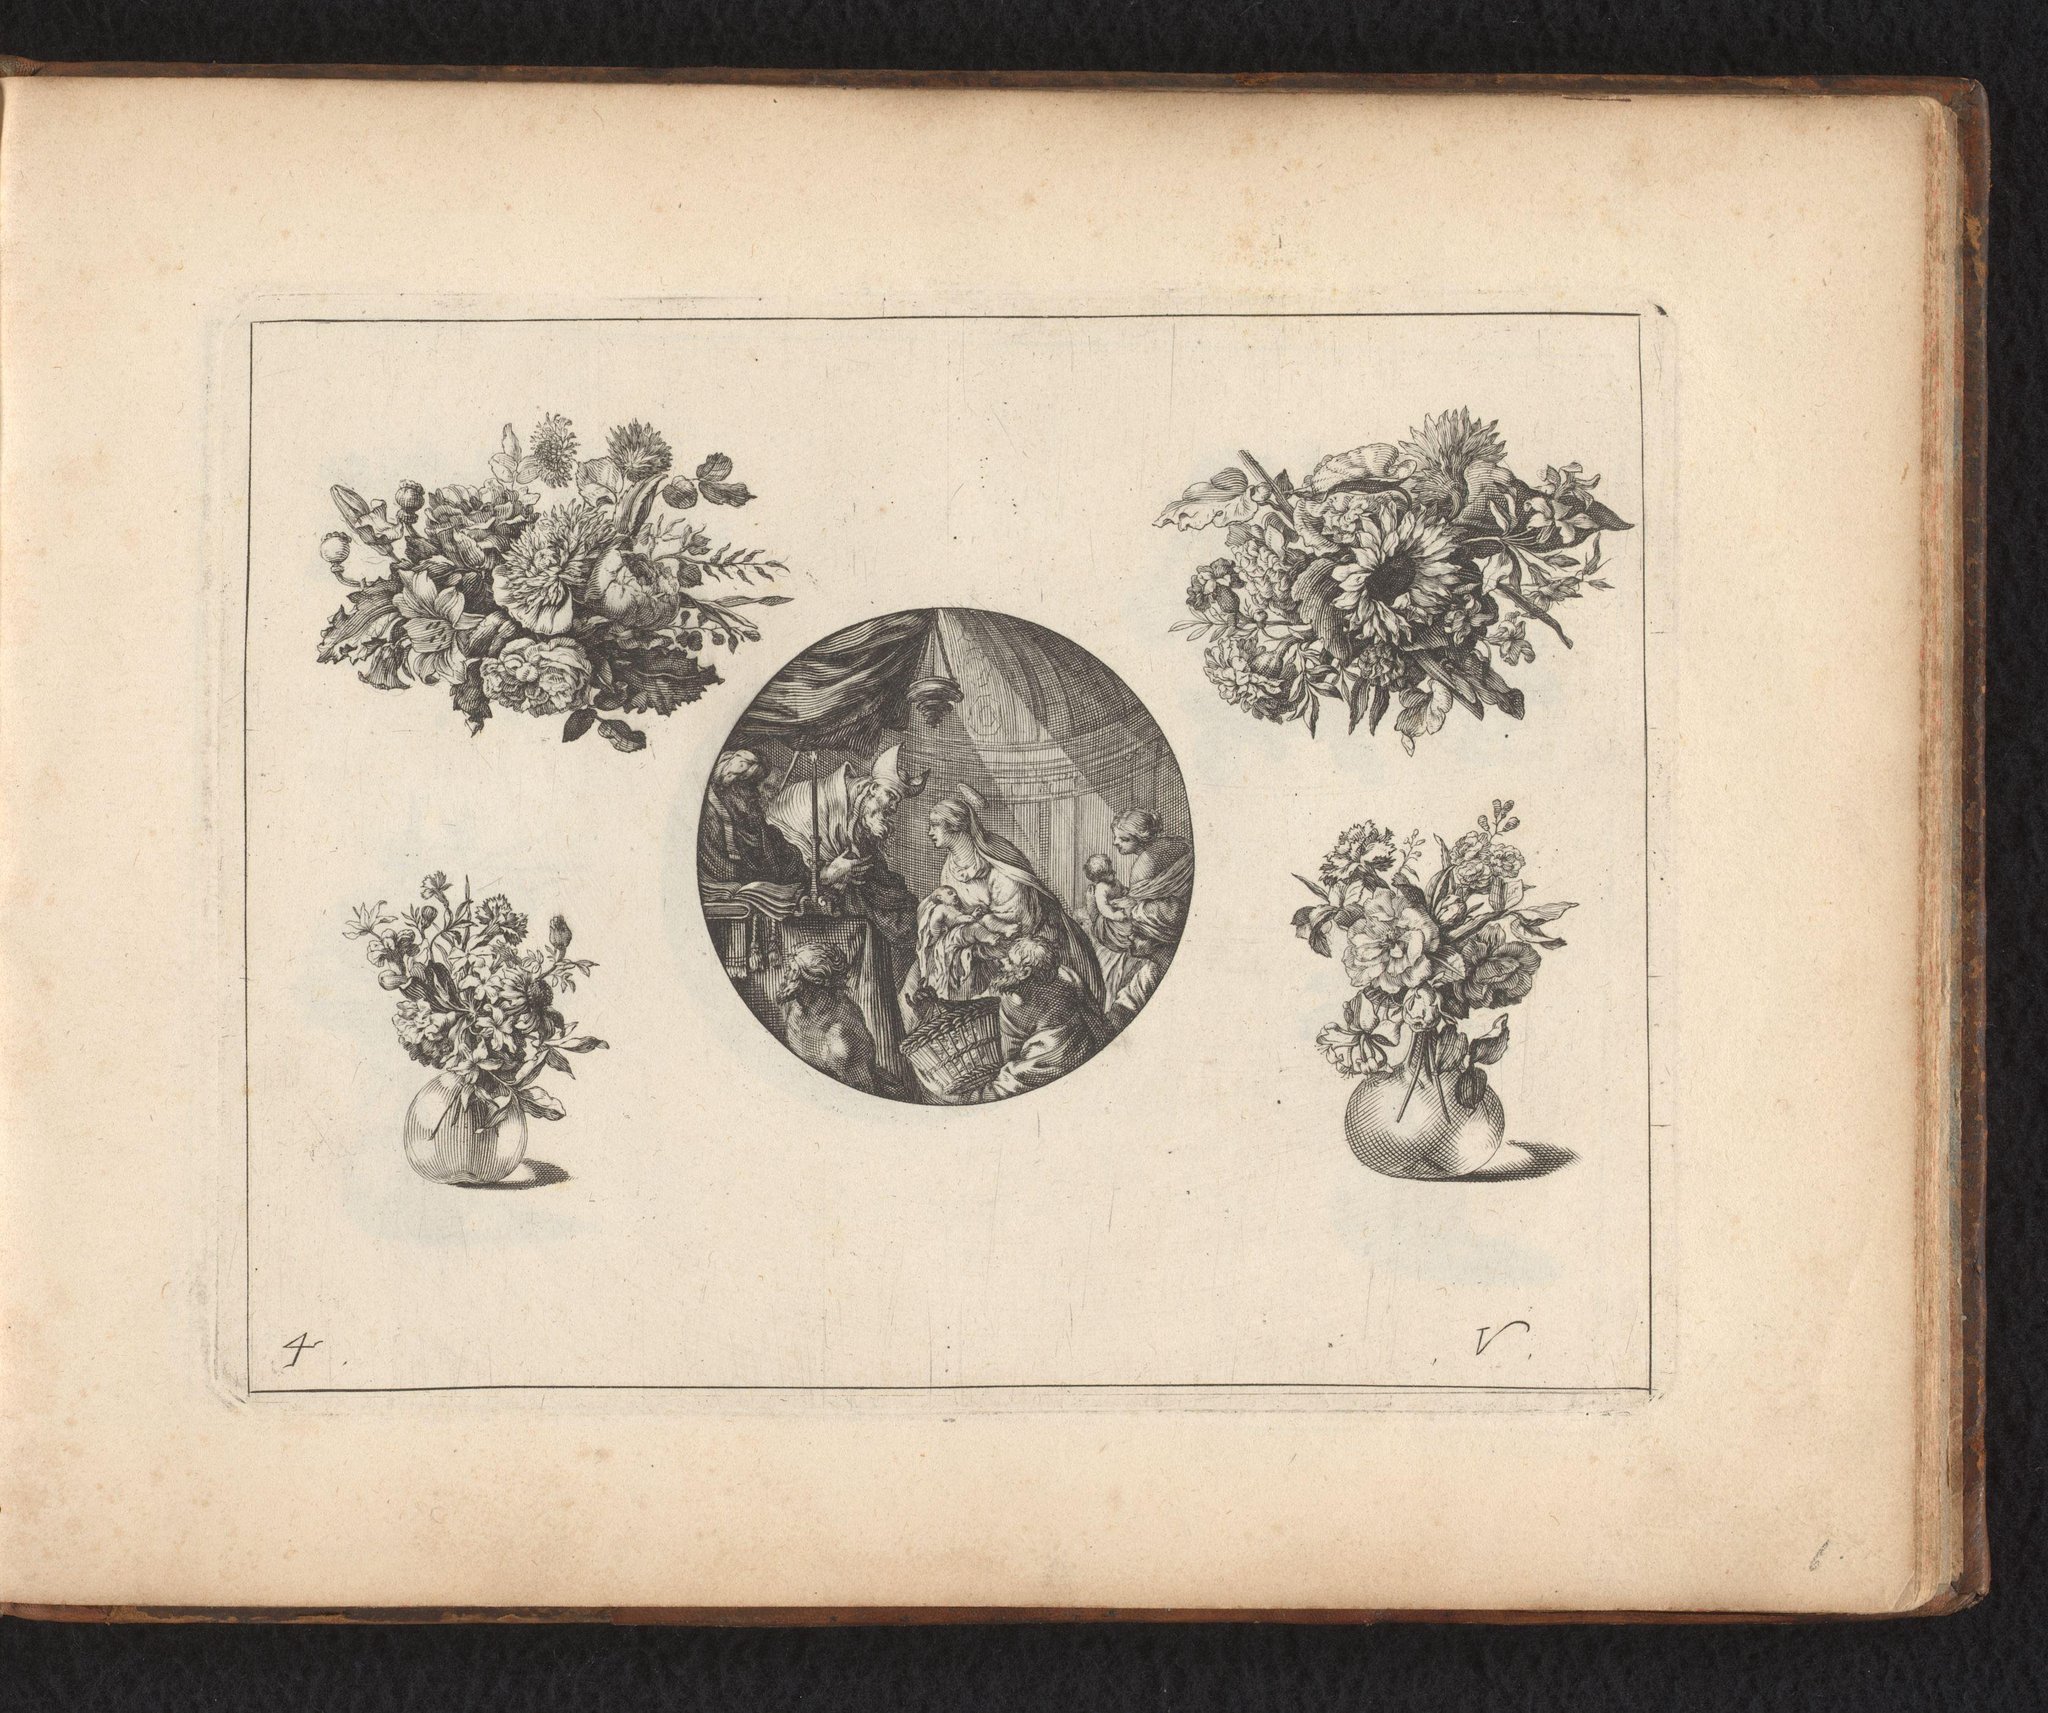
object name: album leaf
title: Horlogekast met de presentatie van Christus in de tempel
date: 1650-1676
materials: paper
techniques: engraving, etching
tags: presentation of the christ-child in the temple, usually simeon (and anna) present (luke 2:22-39)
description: Zowel links als rechts van de horlogekast: een boeket en bloemen in een vaas. Deze prent maakt deel uit van een album.